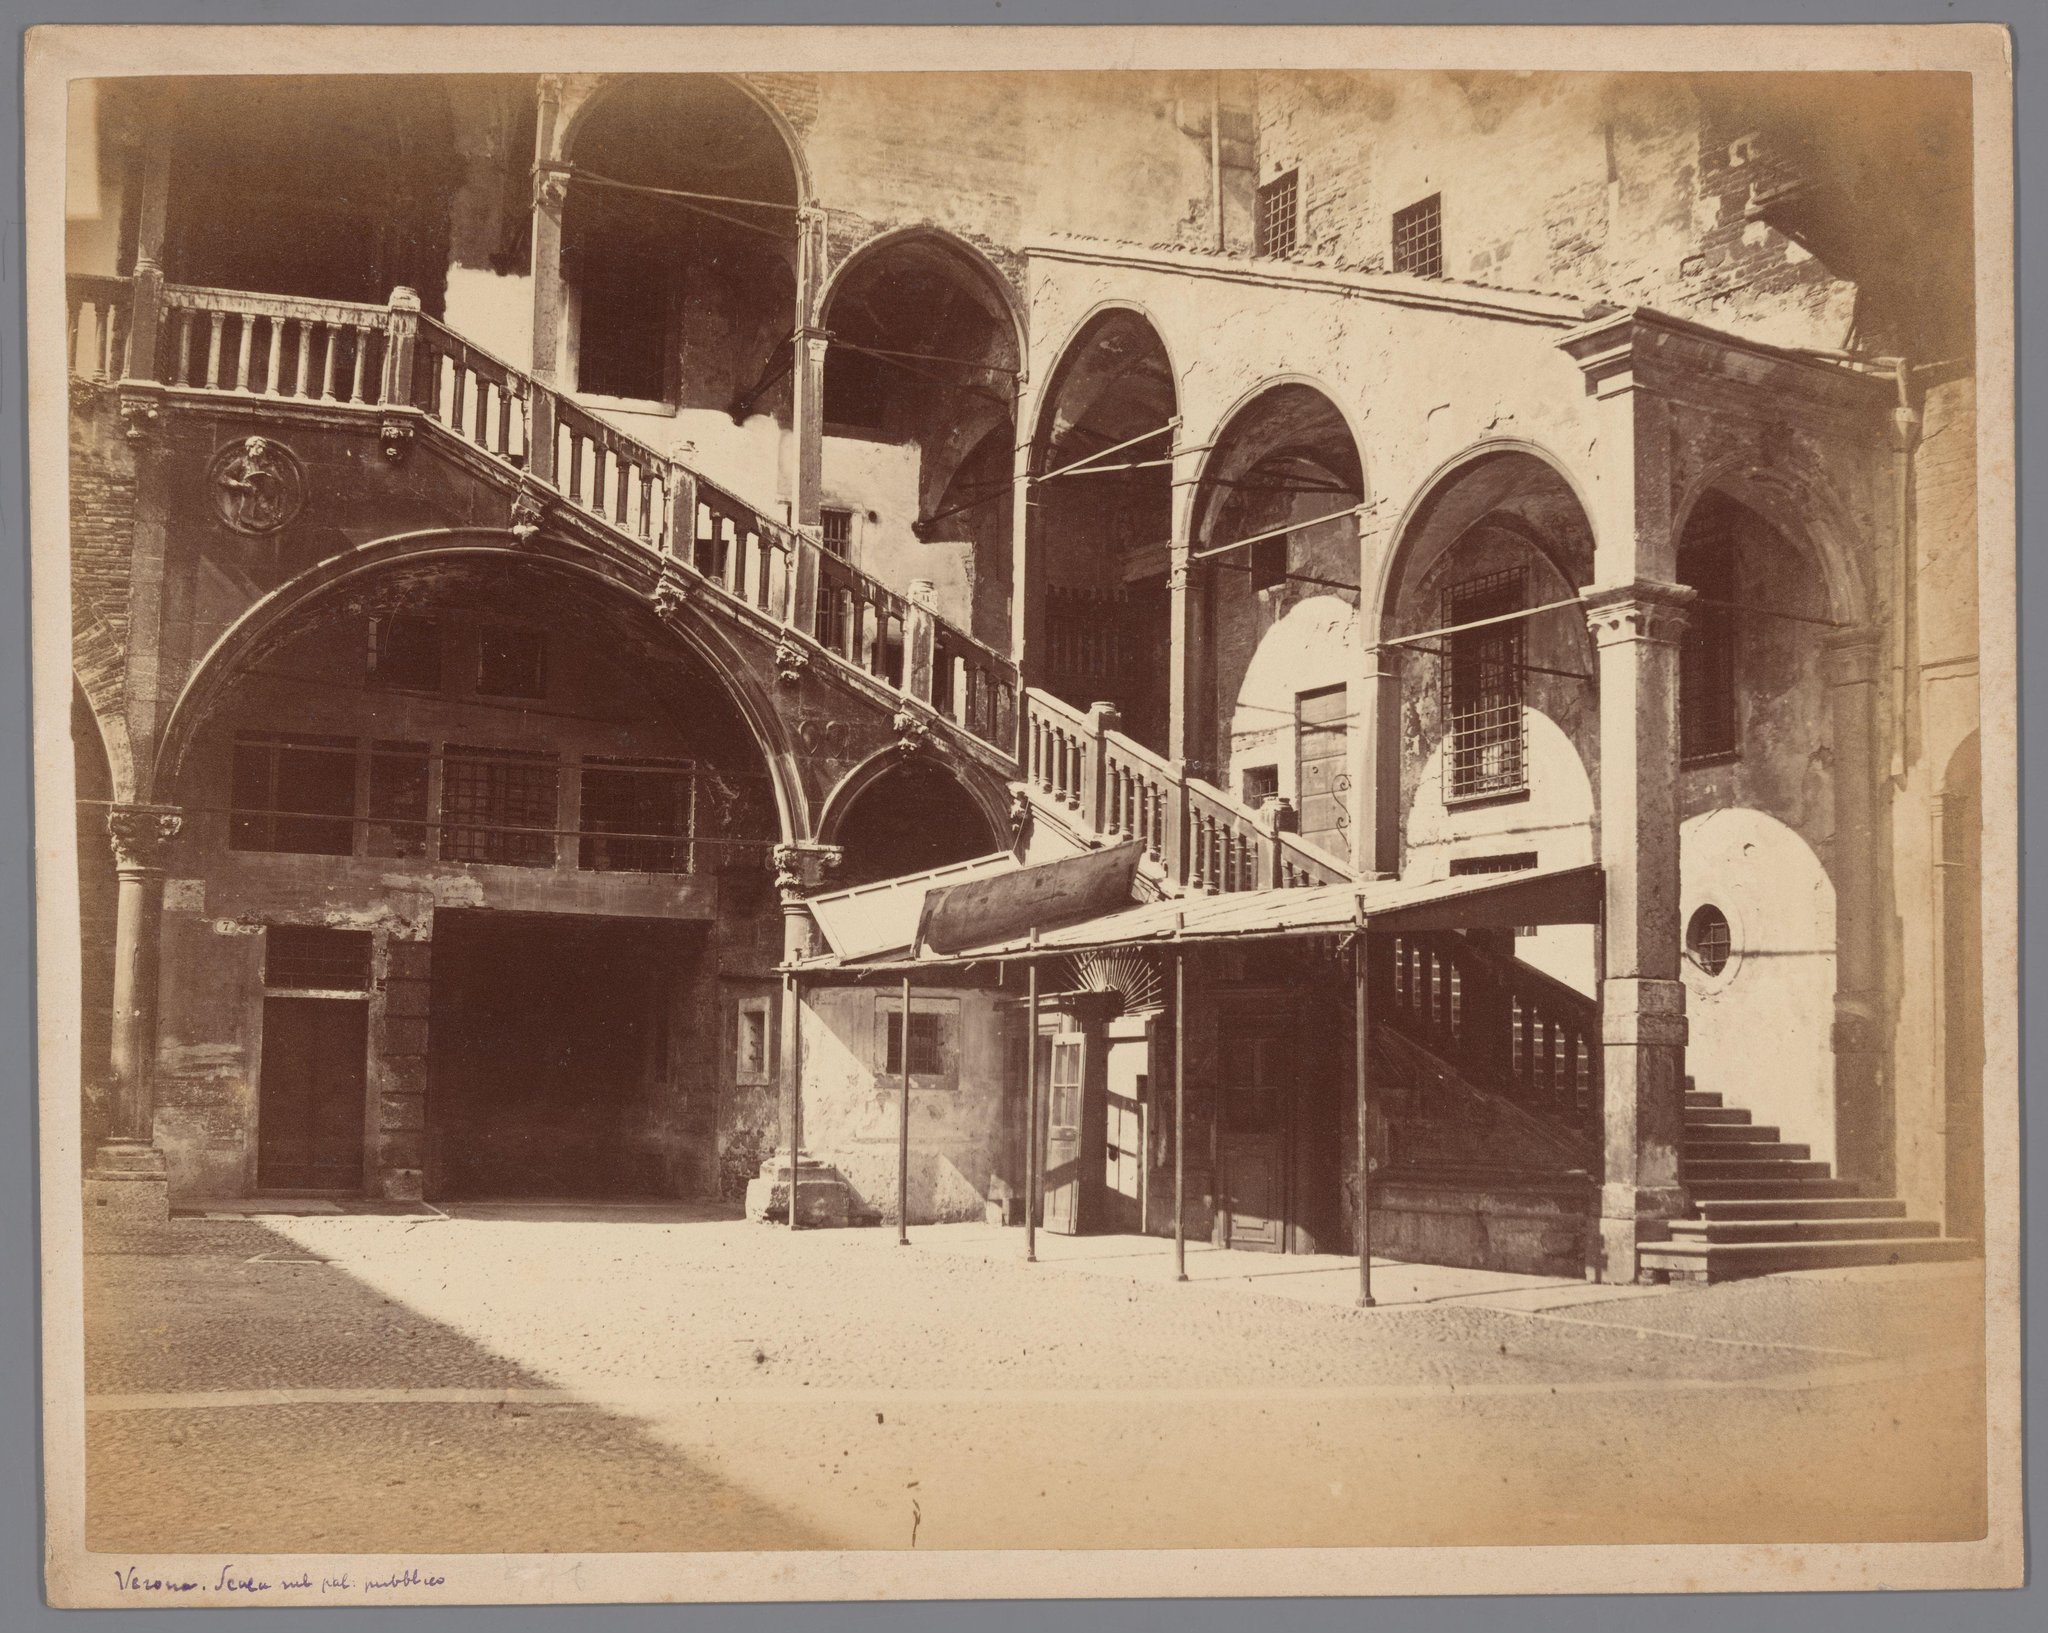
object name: photograph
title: Verona - Scala nel Pal. Pubblico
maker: Anonymous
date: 1851-1900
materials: cardboard, paper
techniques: albumen print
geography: verona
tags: staircase, courtyard